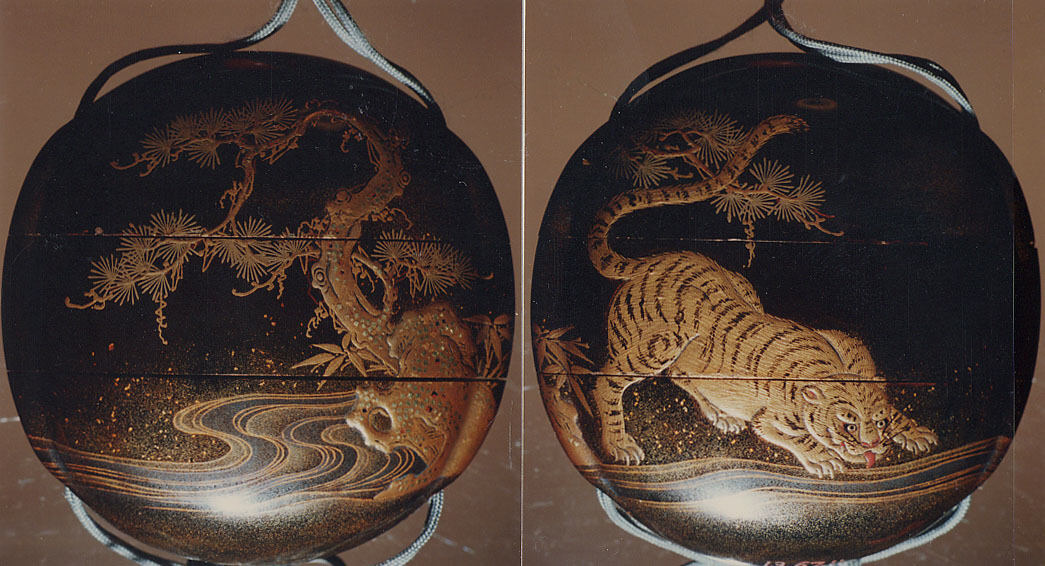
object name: inrō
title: Inrō with Tiger Drinking from a River beside Rocks and Pine Tree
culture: japanese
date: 1801-1833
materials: coral, gold, gold foil, ivory, silver, wood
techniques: carving, cutting, hiramakie, lacquer, maki-e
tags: tigers,rivers,trees